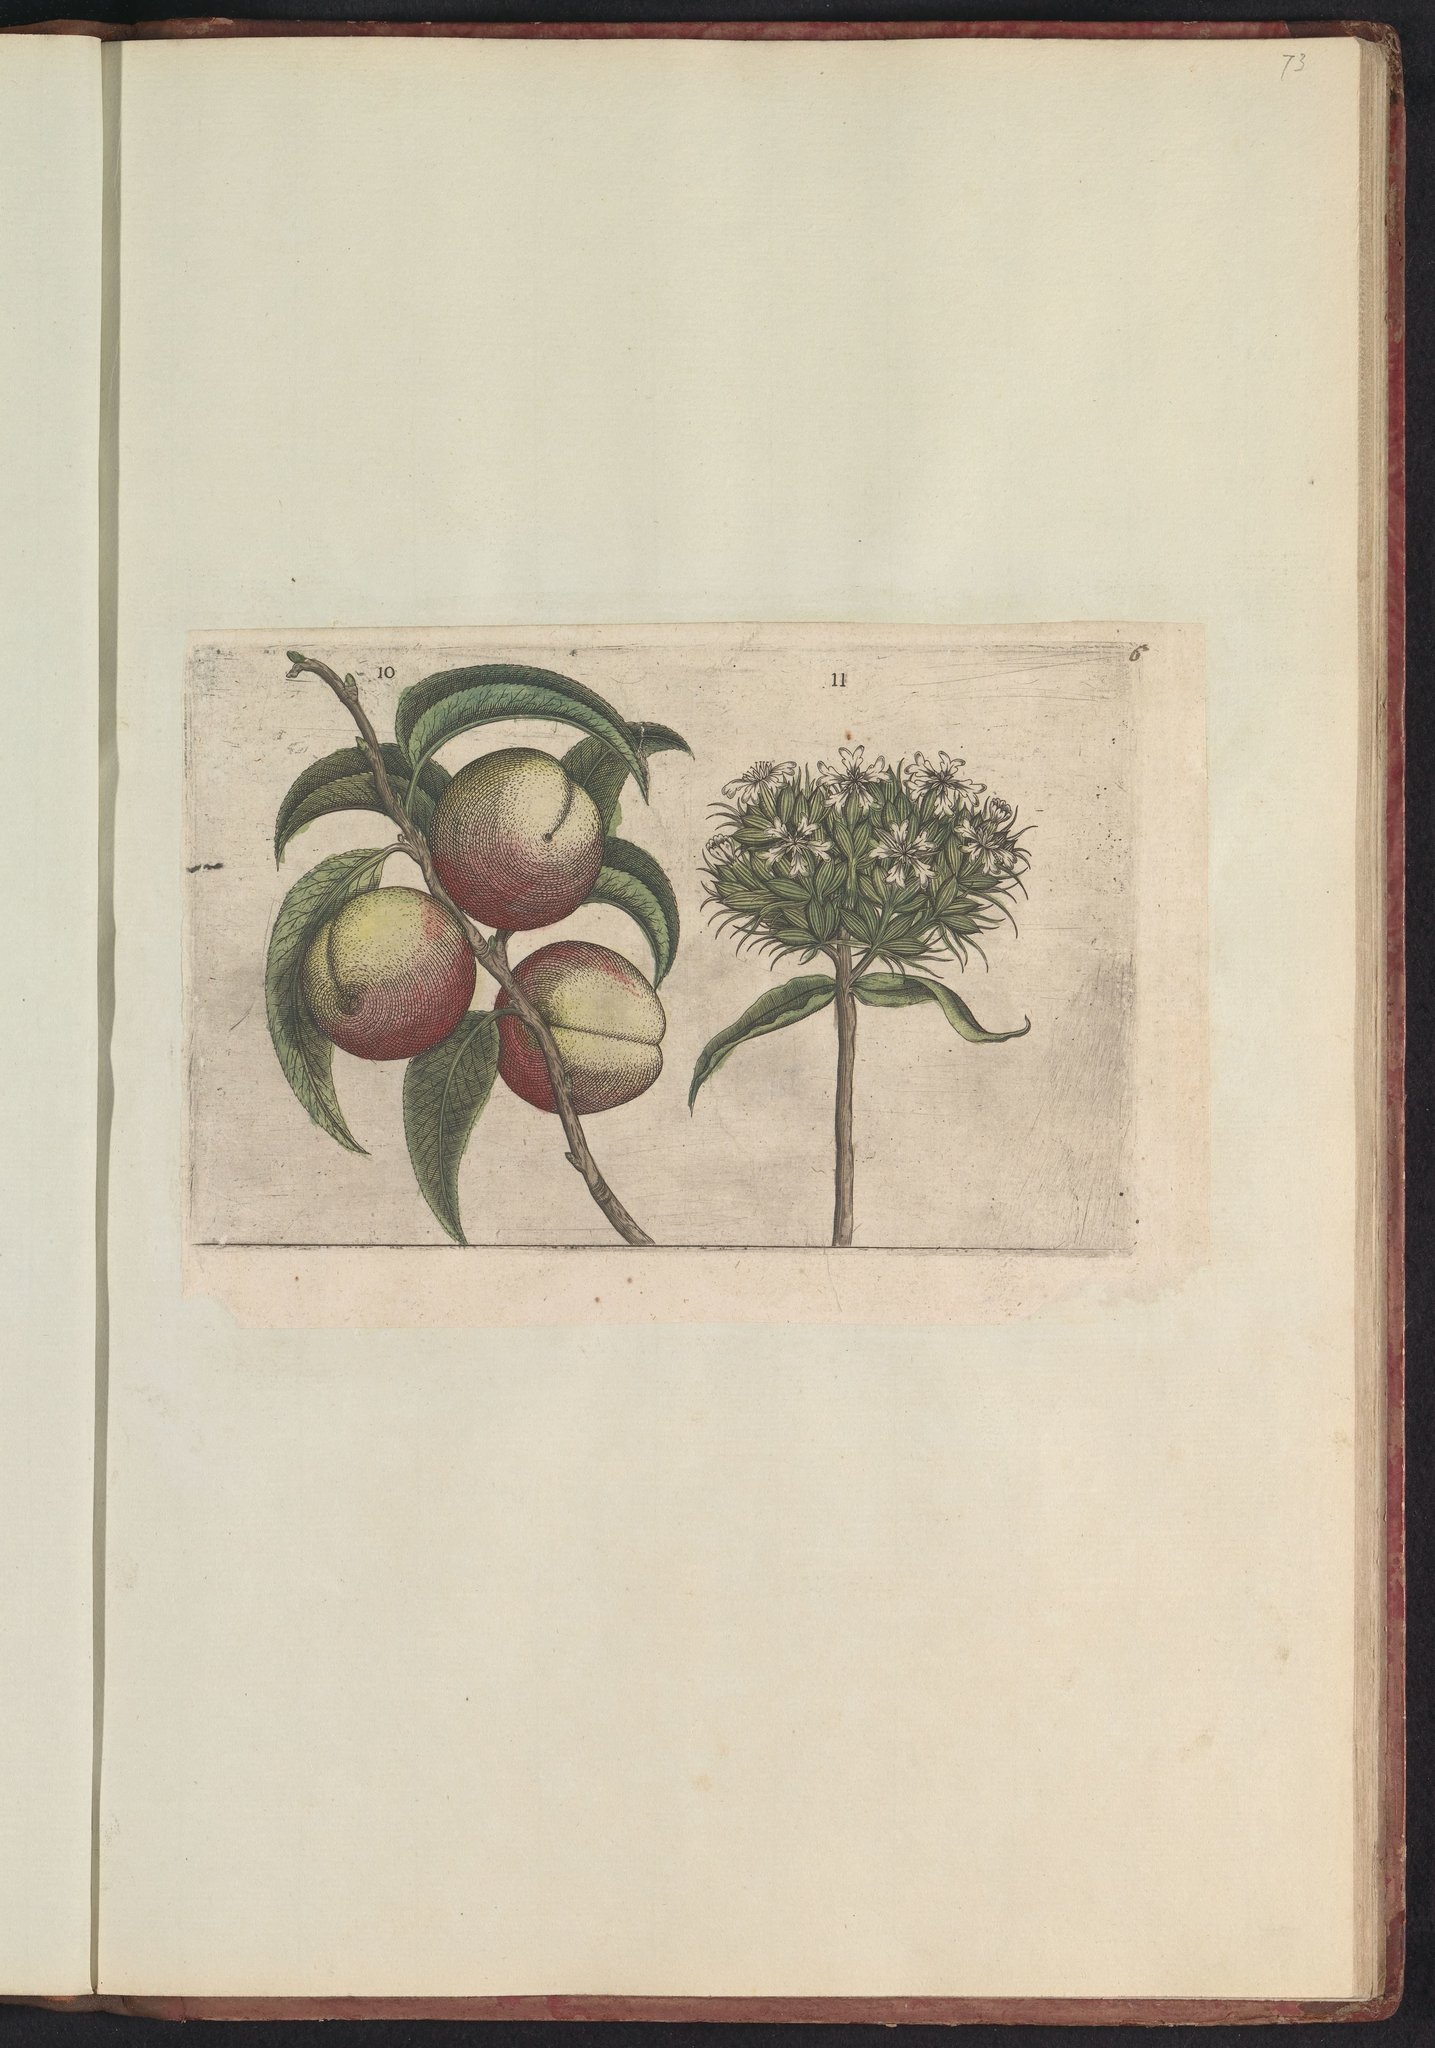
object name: print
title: Perzik (Prunus persica) en brandende liefde (Silene chalcedonica)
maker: Anonymous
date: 1604-1632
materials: ink, paper, watercolor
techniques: engraving, hand coloring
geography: cologne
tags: flowers: burning love, fruits: peach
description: Perzik en brandende liefde. Figs. 10 en 11 op een blad met de hand genummerd 6. In: Anselmi Boëtii de Boot I.C. Brugensis & Rodolphi II. Imp. Roman. medici a cubiculis Florum, Herbarum, ac fructuum selectiorum icones, & vires pleraeque hactenus ignotæ. Onderdeel van het album met bladen en platen uit De Boodts herbarium van 1640. Het twaalfde van twaalf albums met aquarellen van dieren, vogels en planten bekend rond 1600, gemaakt in opdracht van keizer Rudolf II.